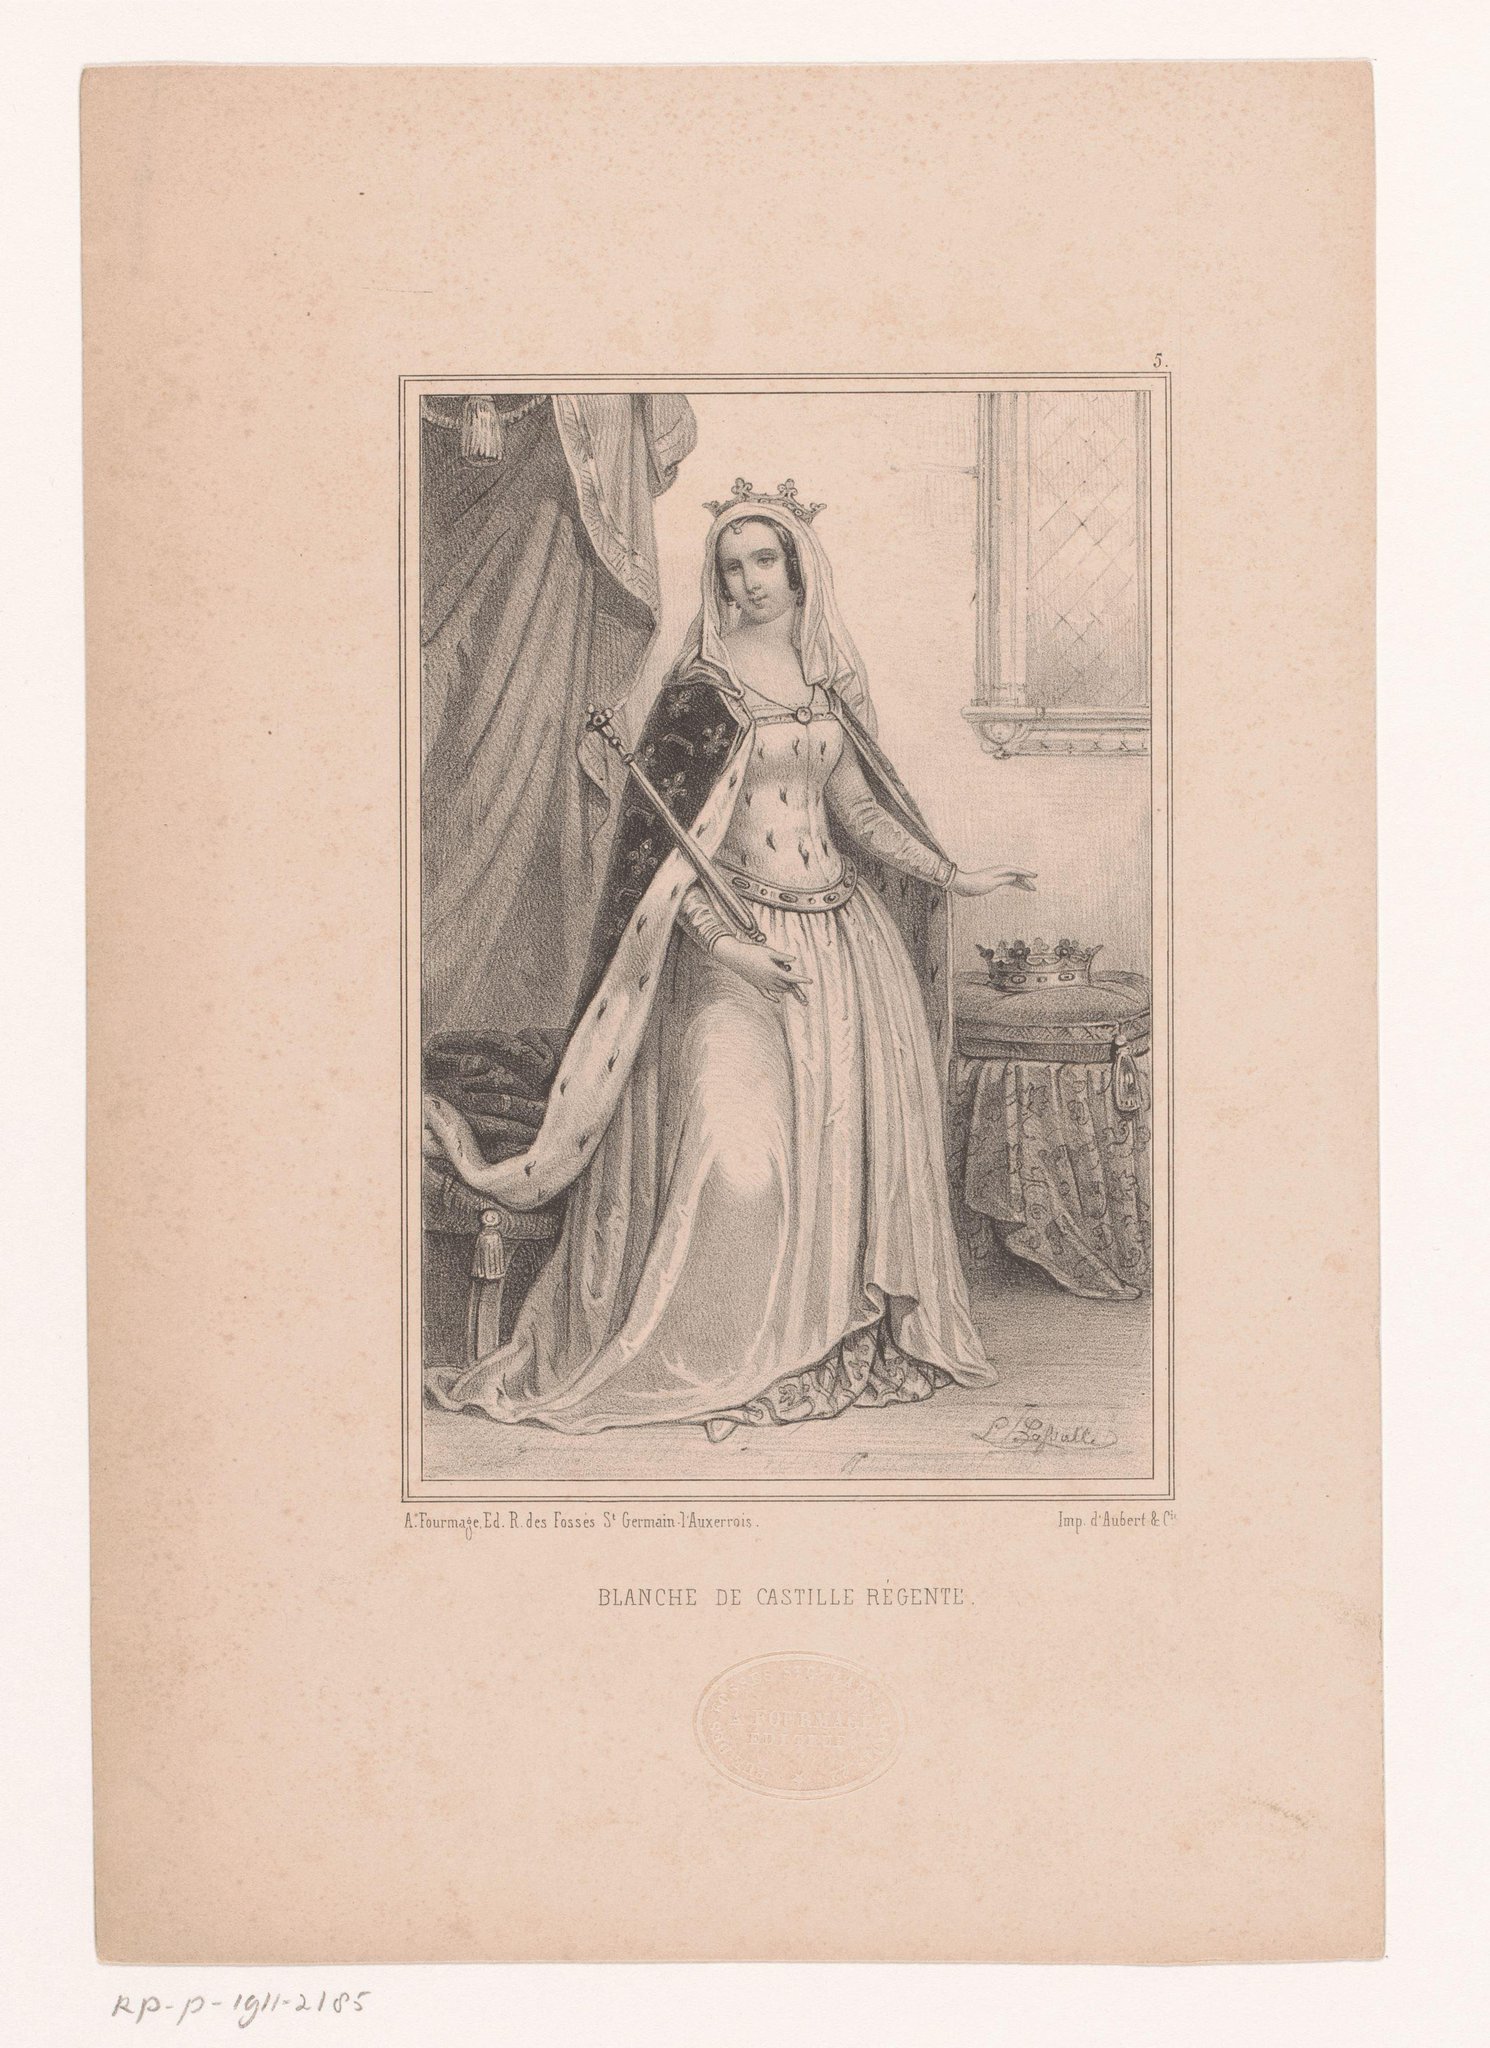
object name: print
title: Blanca van Castilië als regentes van Frankrijk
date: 1841-1850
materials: paper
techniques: lithograph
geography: paris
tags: paris, historical persons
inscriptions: check stamp: Lugt 5285, collector's mark: Lugt 2228a